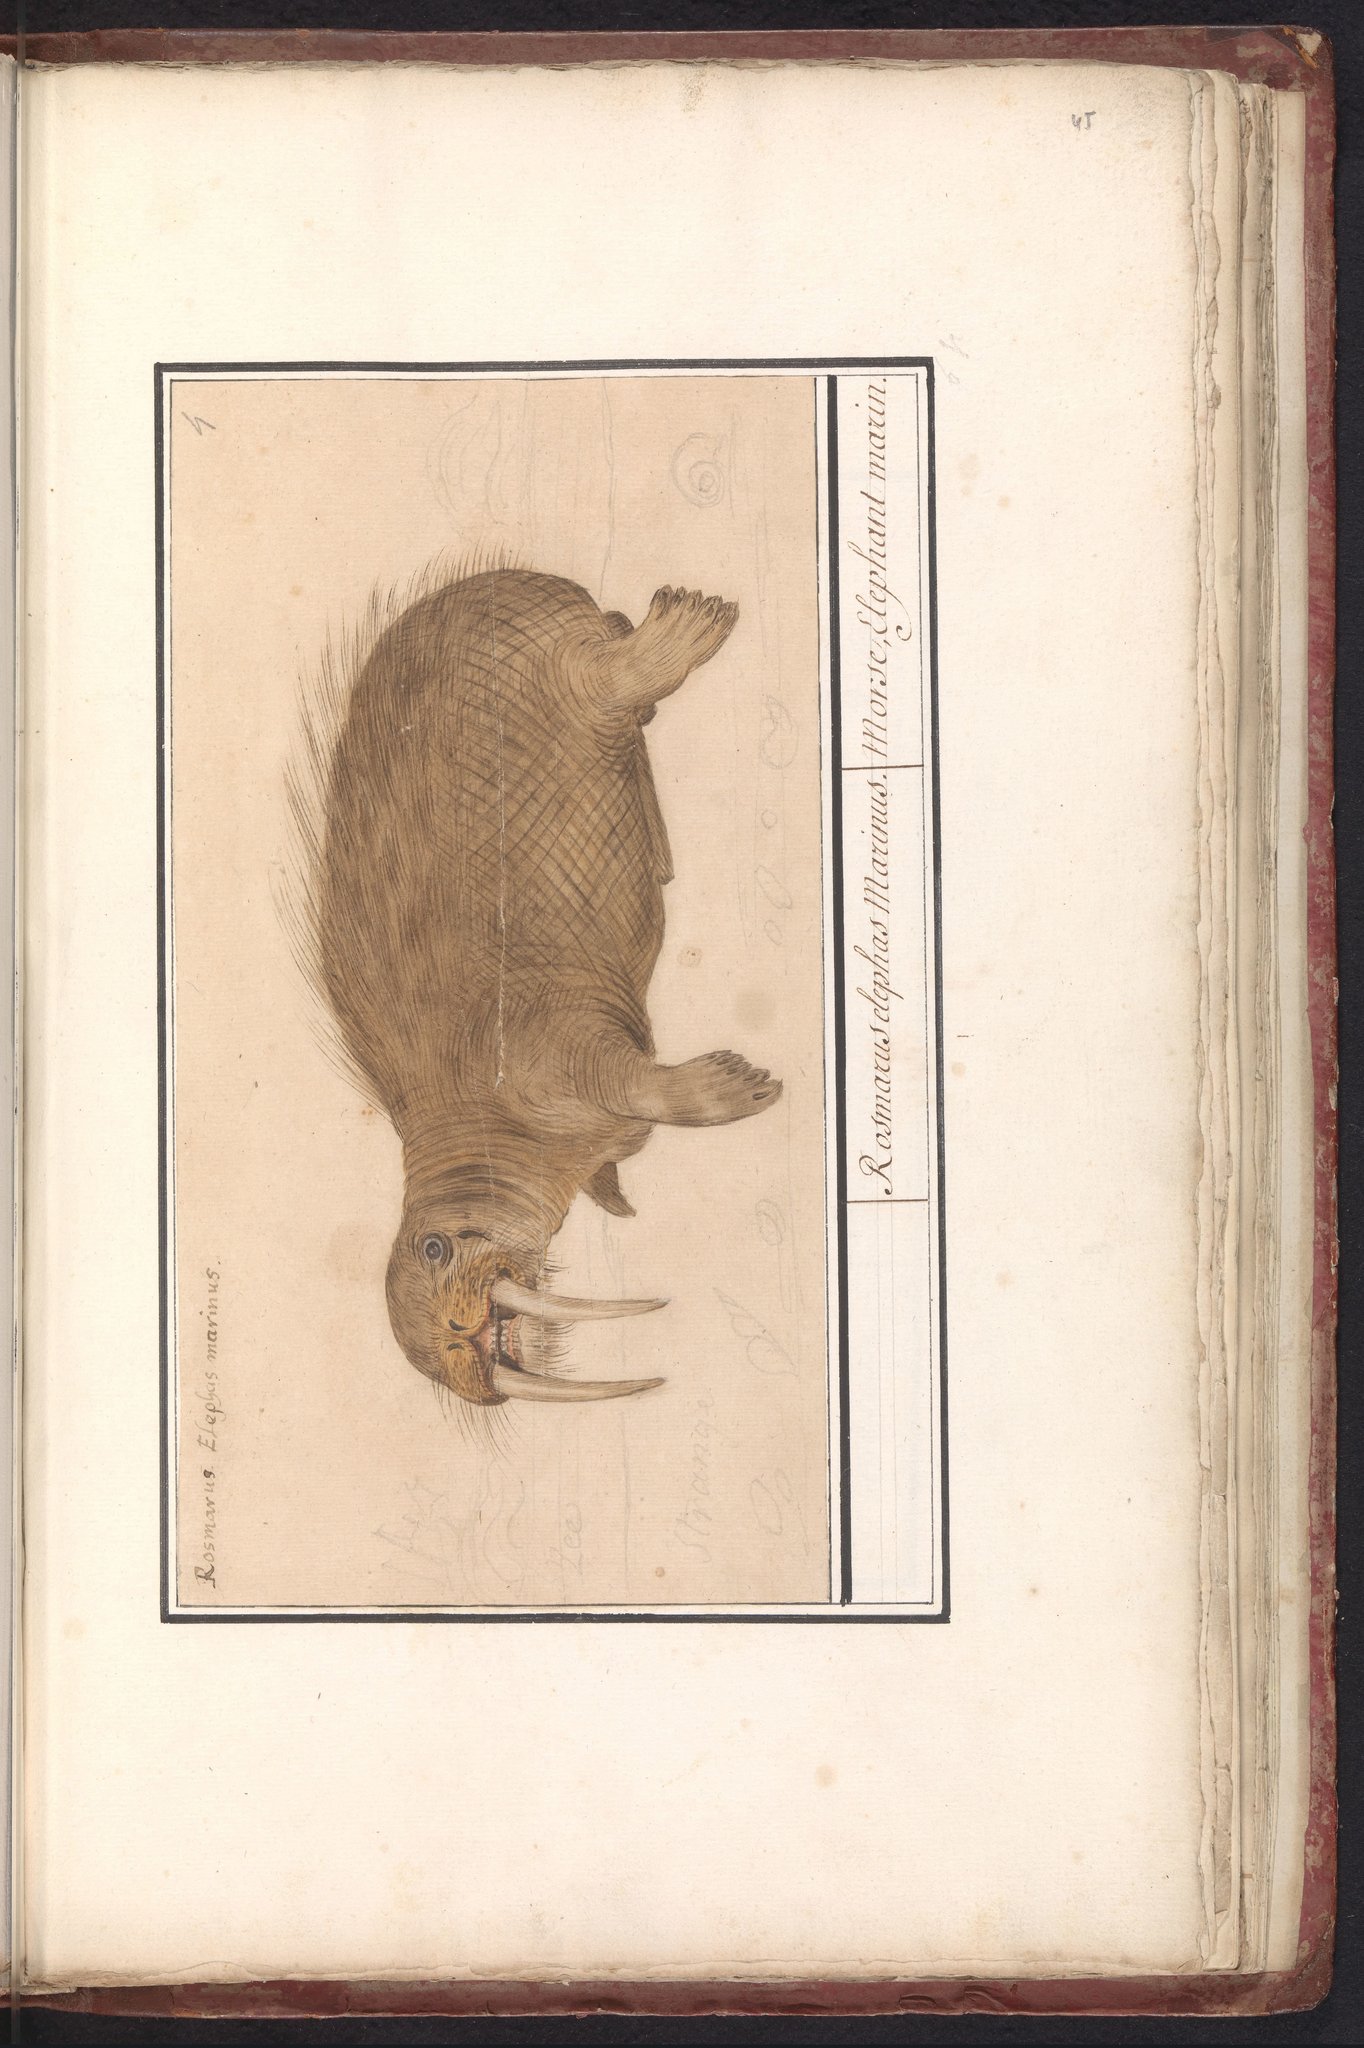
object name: drawing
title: Rosmarcus elephas Marinus. / Morse, Elephant marin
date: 1596-1610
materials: paint, ink, paper, pencil, watercolor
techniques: brush, pen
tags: swimming mammals: walrus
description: Walrus. Genummerd rechtsboven: 4. Linksboven de naam in het Latijn. Onderdeel van het tweede album met tekeningen van viervoeters. Tweede van twaalf albums met tekeningen van dieren, vogels en planten bekend rond 1600, gemaakt in opdracht van keizer Rudolf II. Met toelichting in Nederlands, Latijn en Frans.